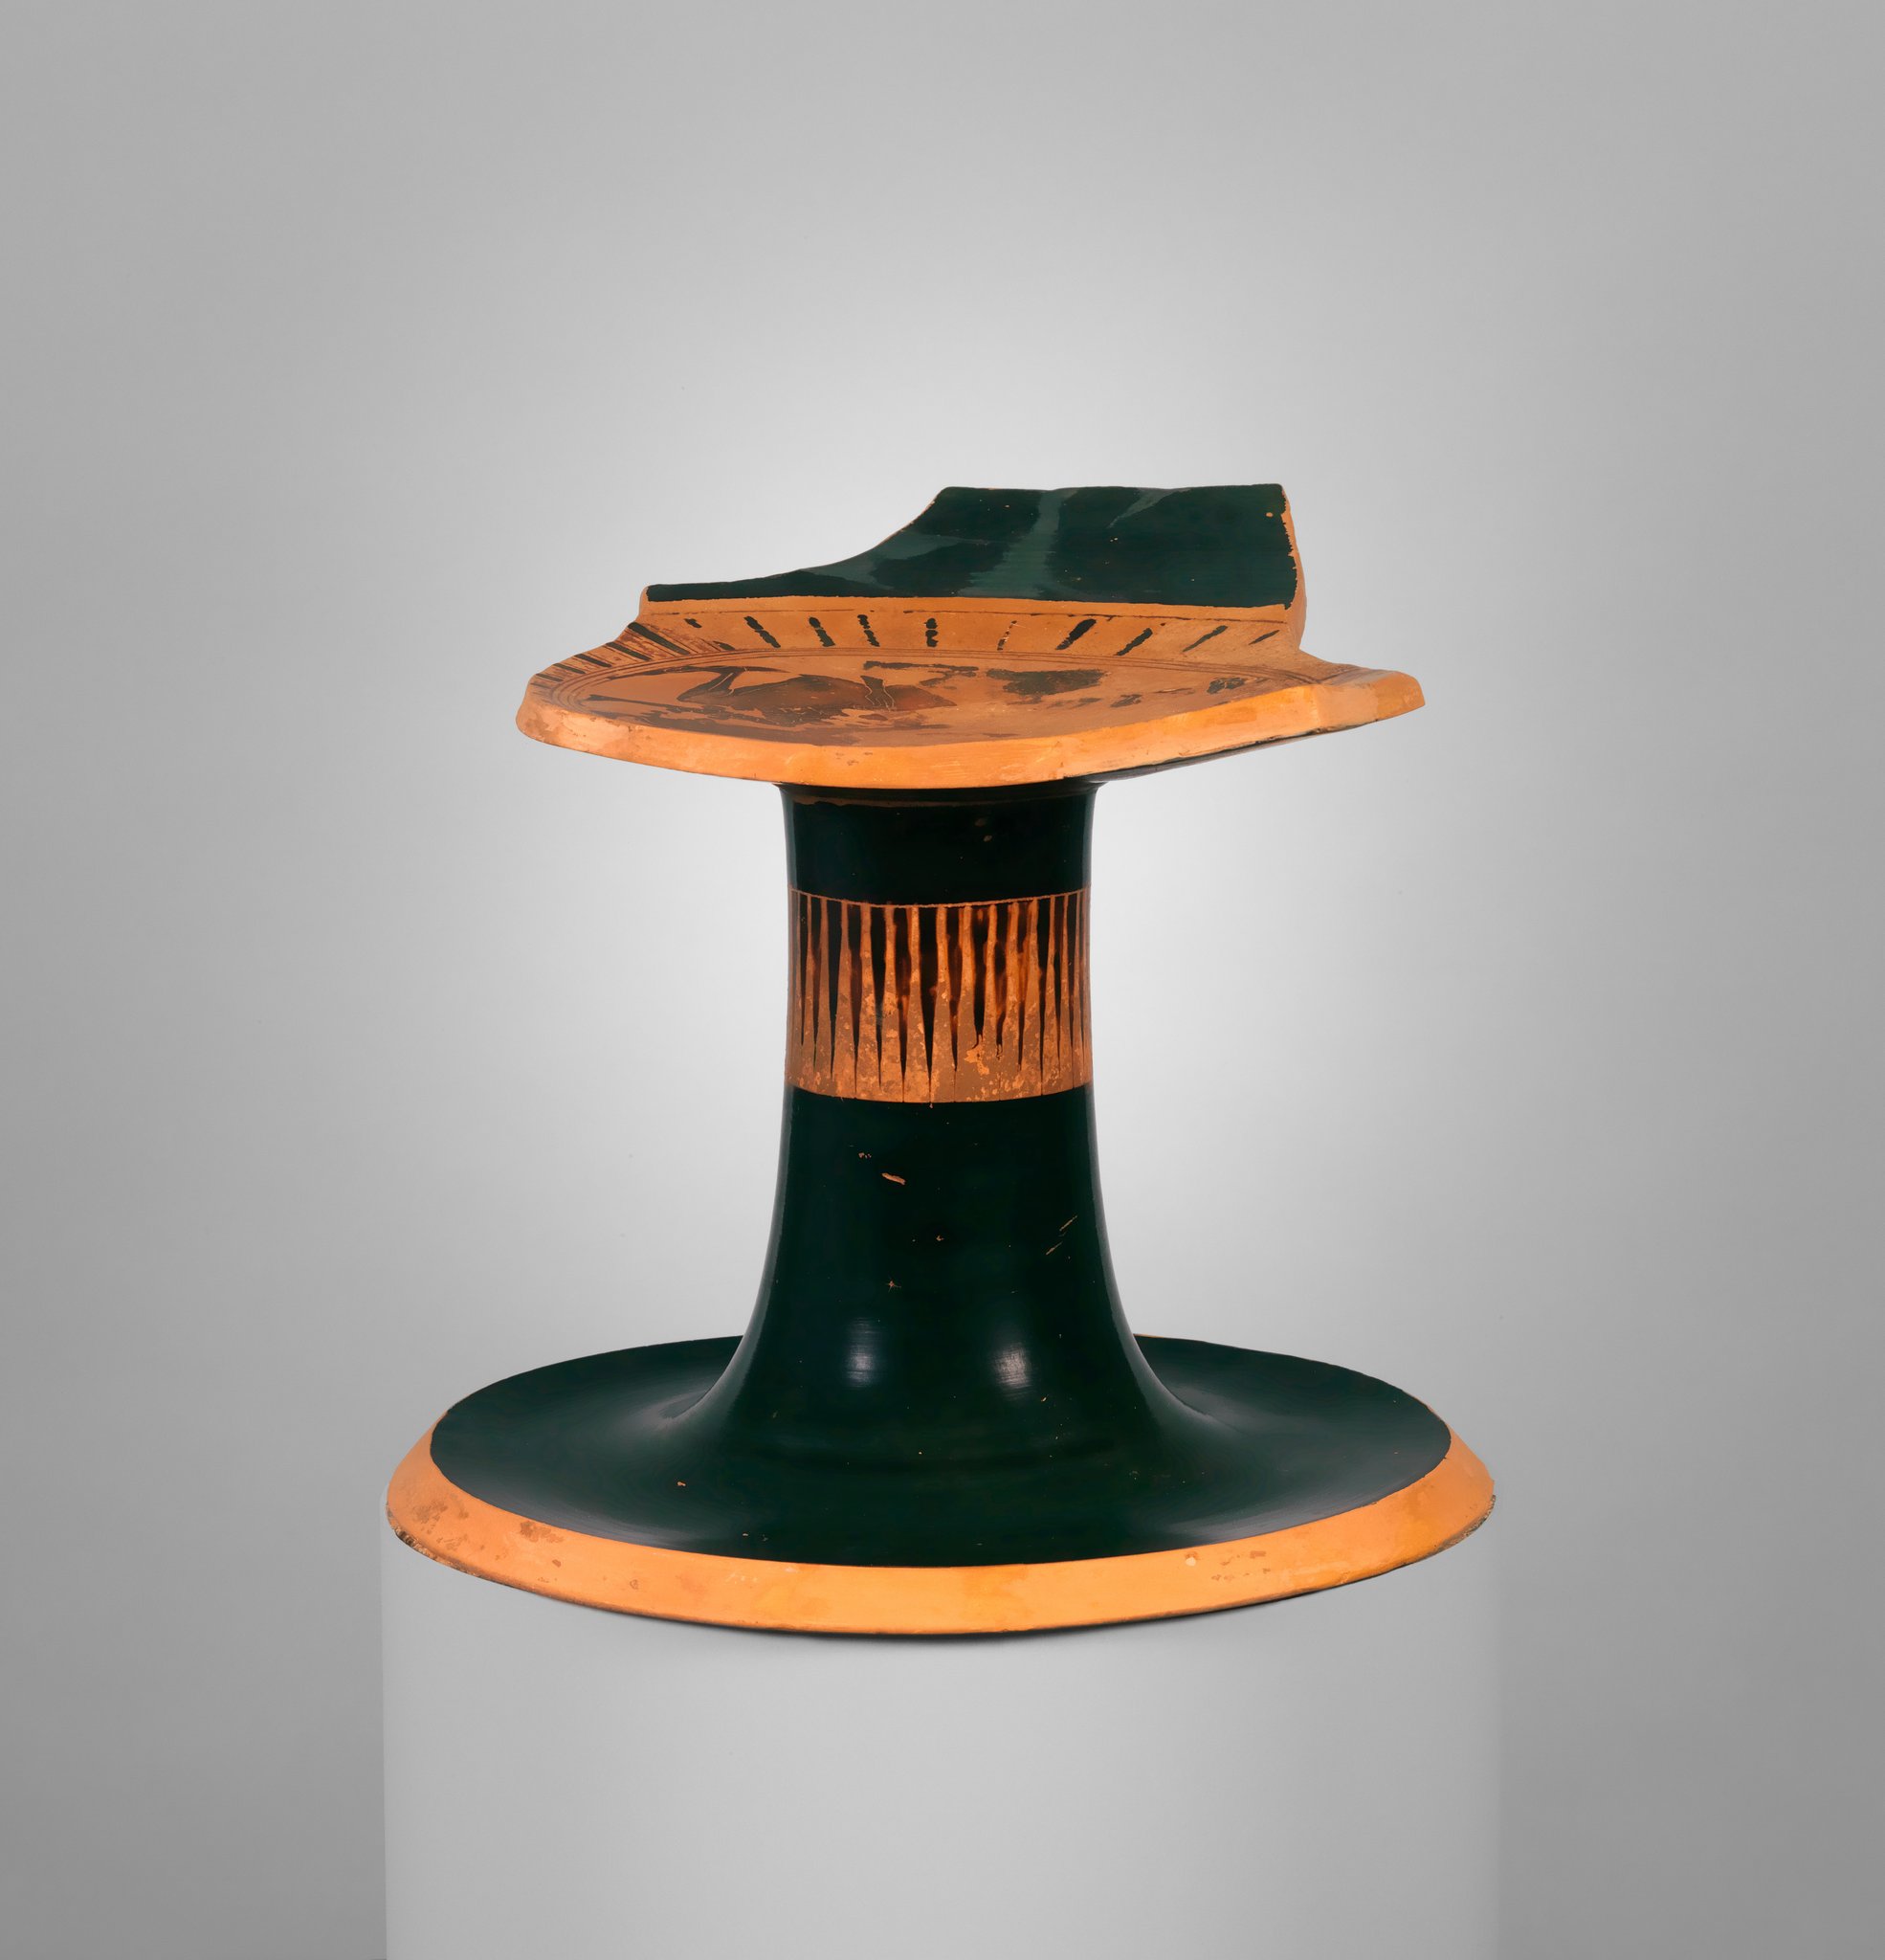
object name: band cup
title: Terracotta kylix:band-cup (drinking cup)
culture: greek, attic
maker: lysippides painter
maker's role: artist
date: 550-526 BCE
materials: terracotta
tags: griffins,lions